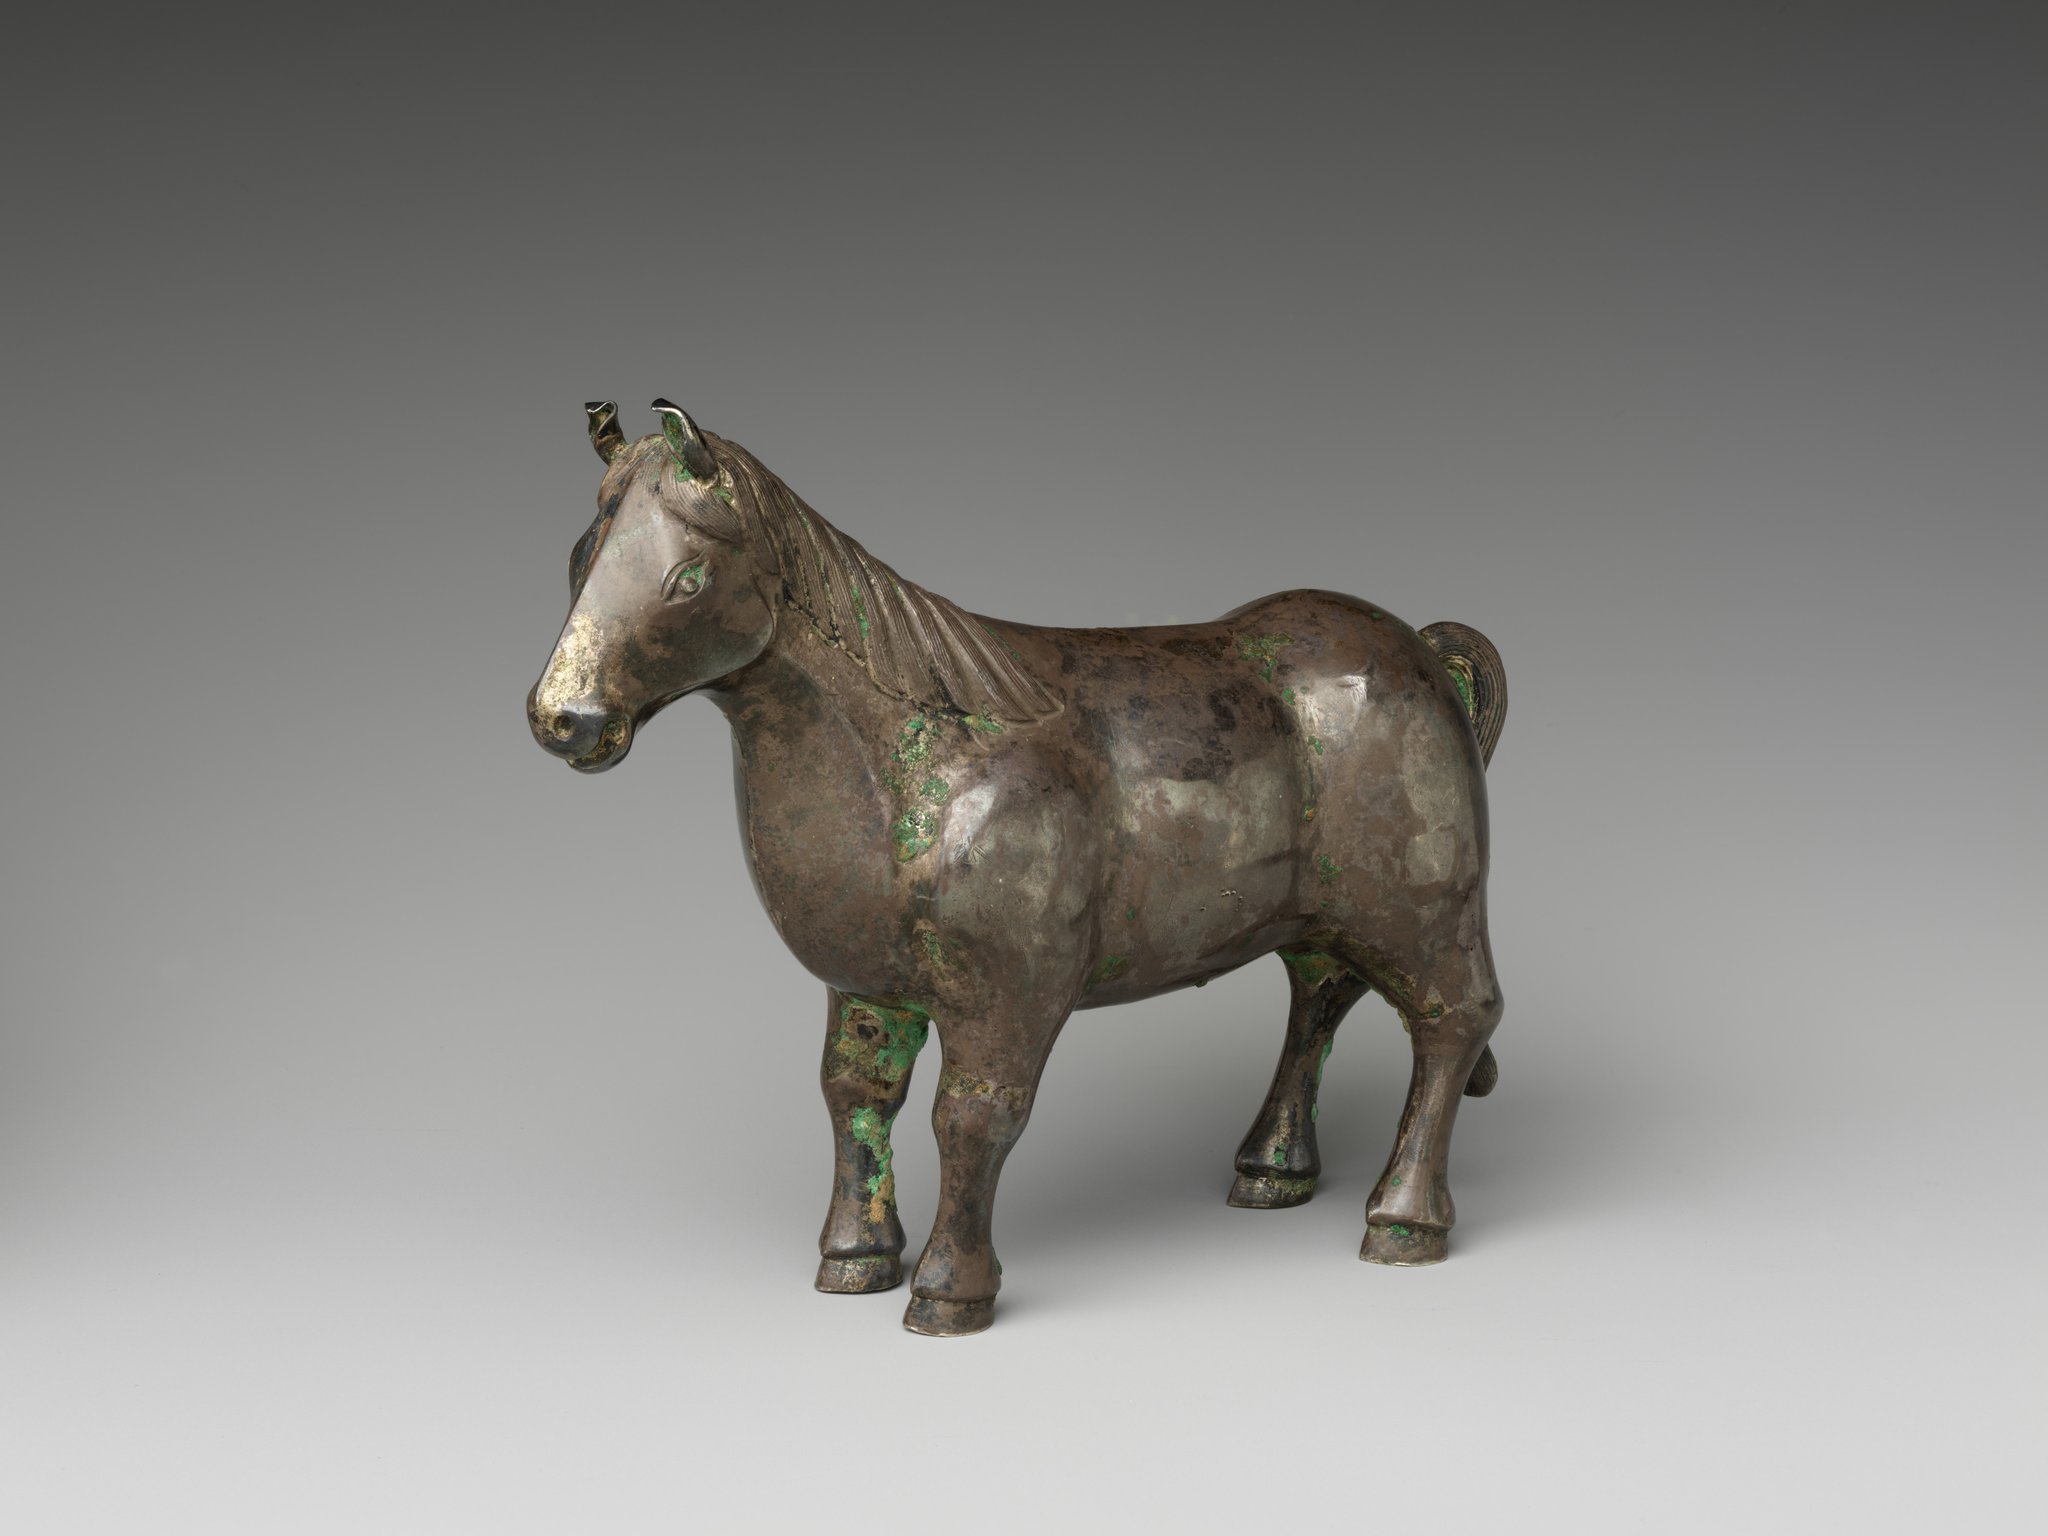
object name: paperweight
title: Paperweight in the shape of a horse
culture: chinese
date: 1201-1400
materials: lead, silver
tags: horses